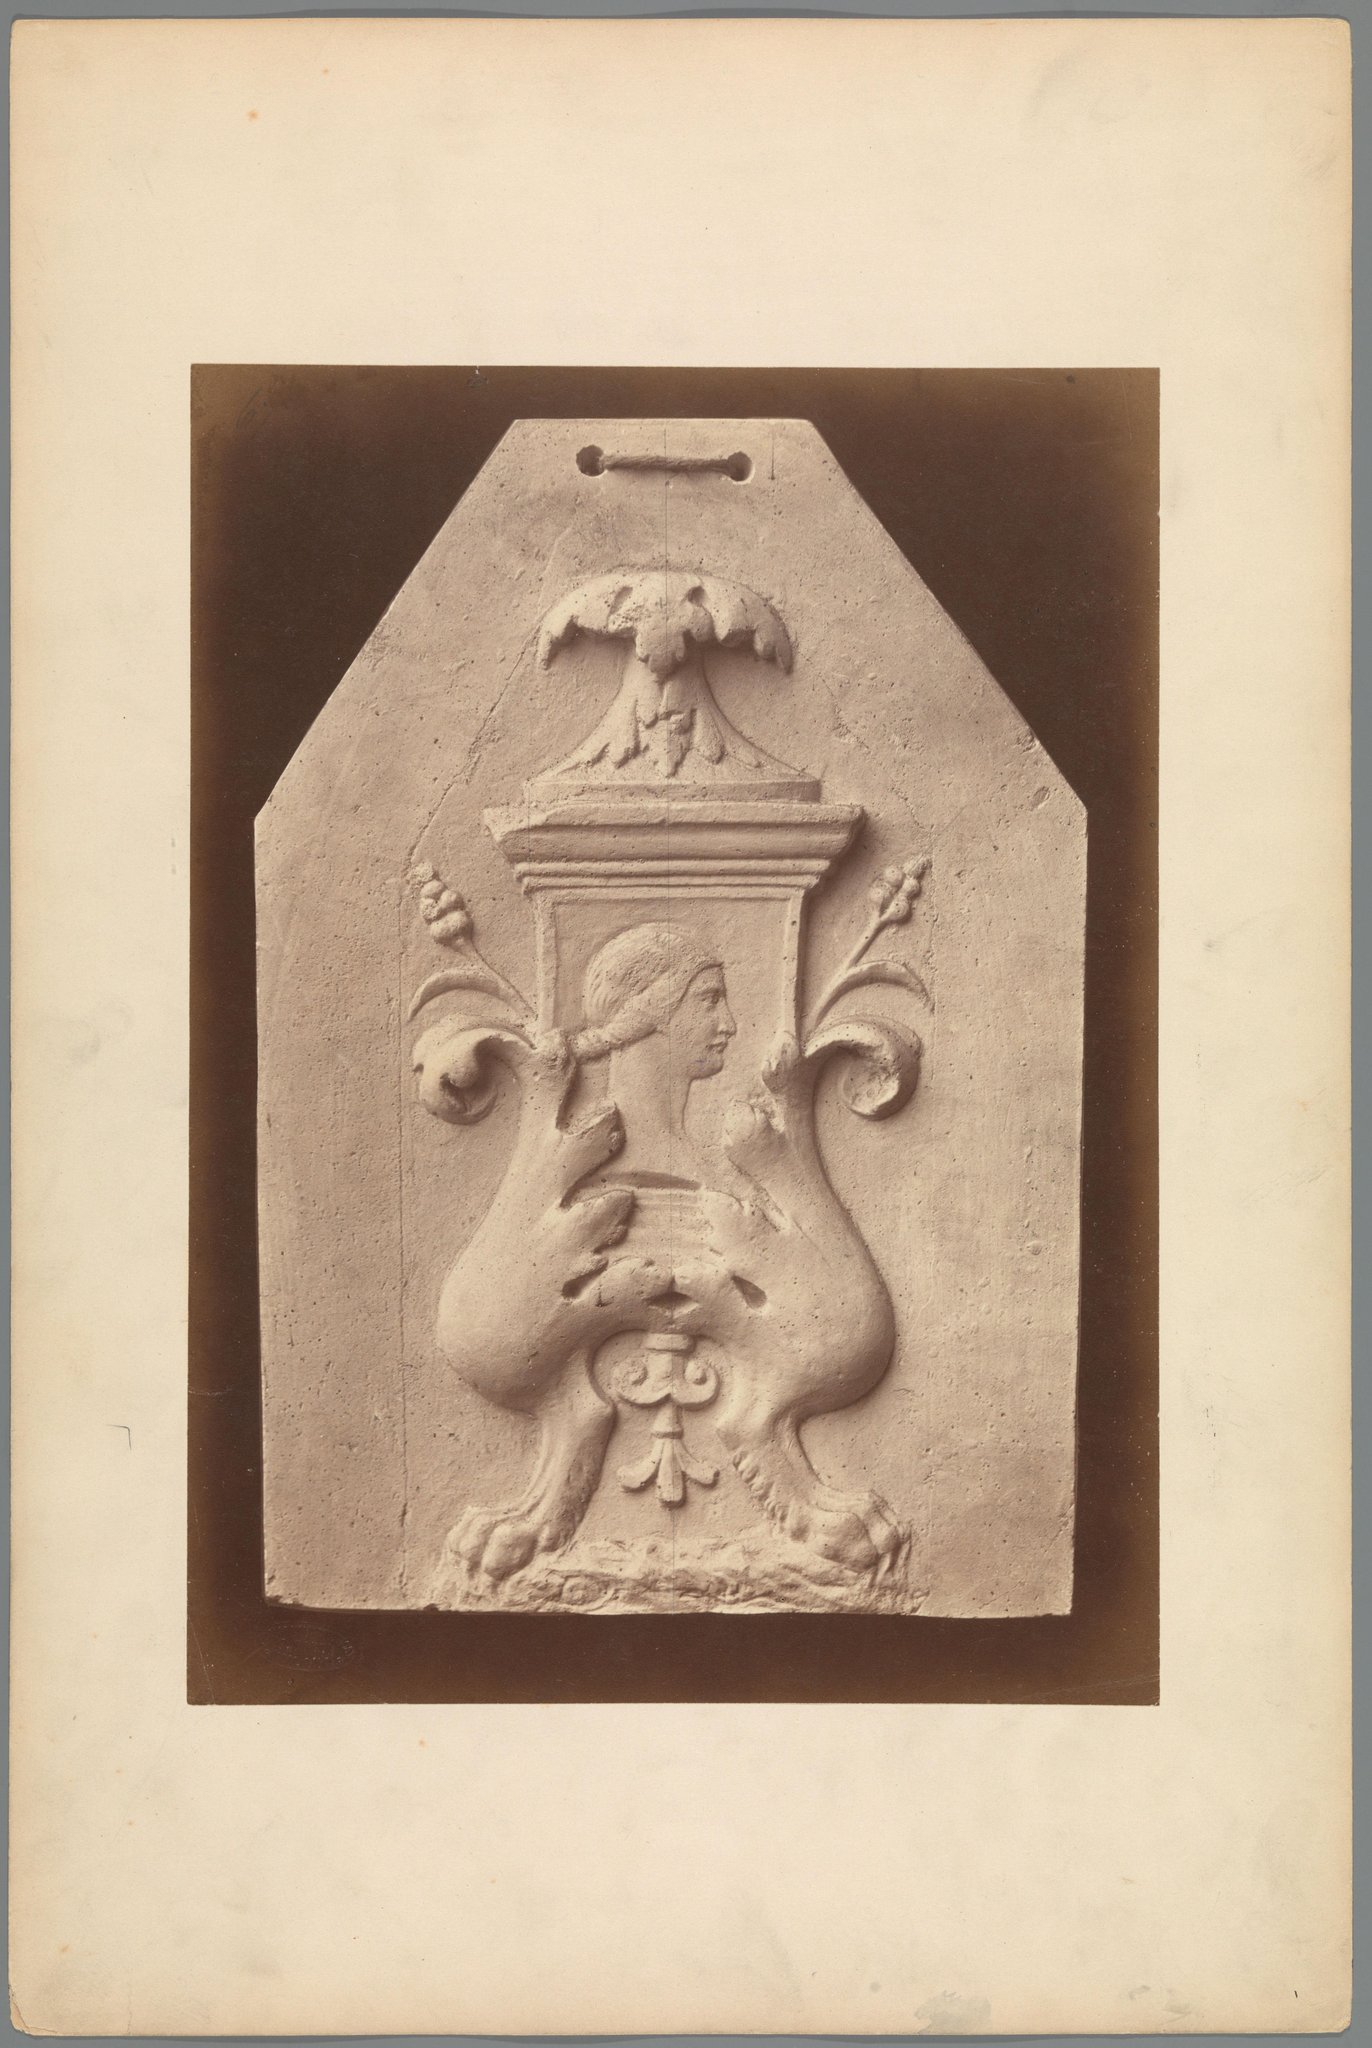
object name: photograph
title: Zeshoekig reliëf met een portret op een houder met leeuwenpoten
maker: pompeo pozzi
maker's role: fotograaf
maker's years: 1817-1880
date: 1850-1880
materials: cardboard, photographic support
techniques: albumen print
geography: europe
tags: portrait, self-portrait of sculptor, ornament derived from plant forms, sculpture (+ relief ~ sculpture), europe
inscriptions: name: ‘FOTOGRAFIA ARTISTICA P.POZZI MILANO’, collector's mark: Lugt 3937